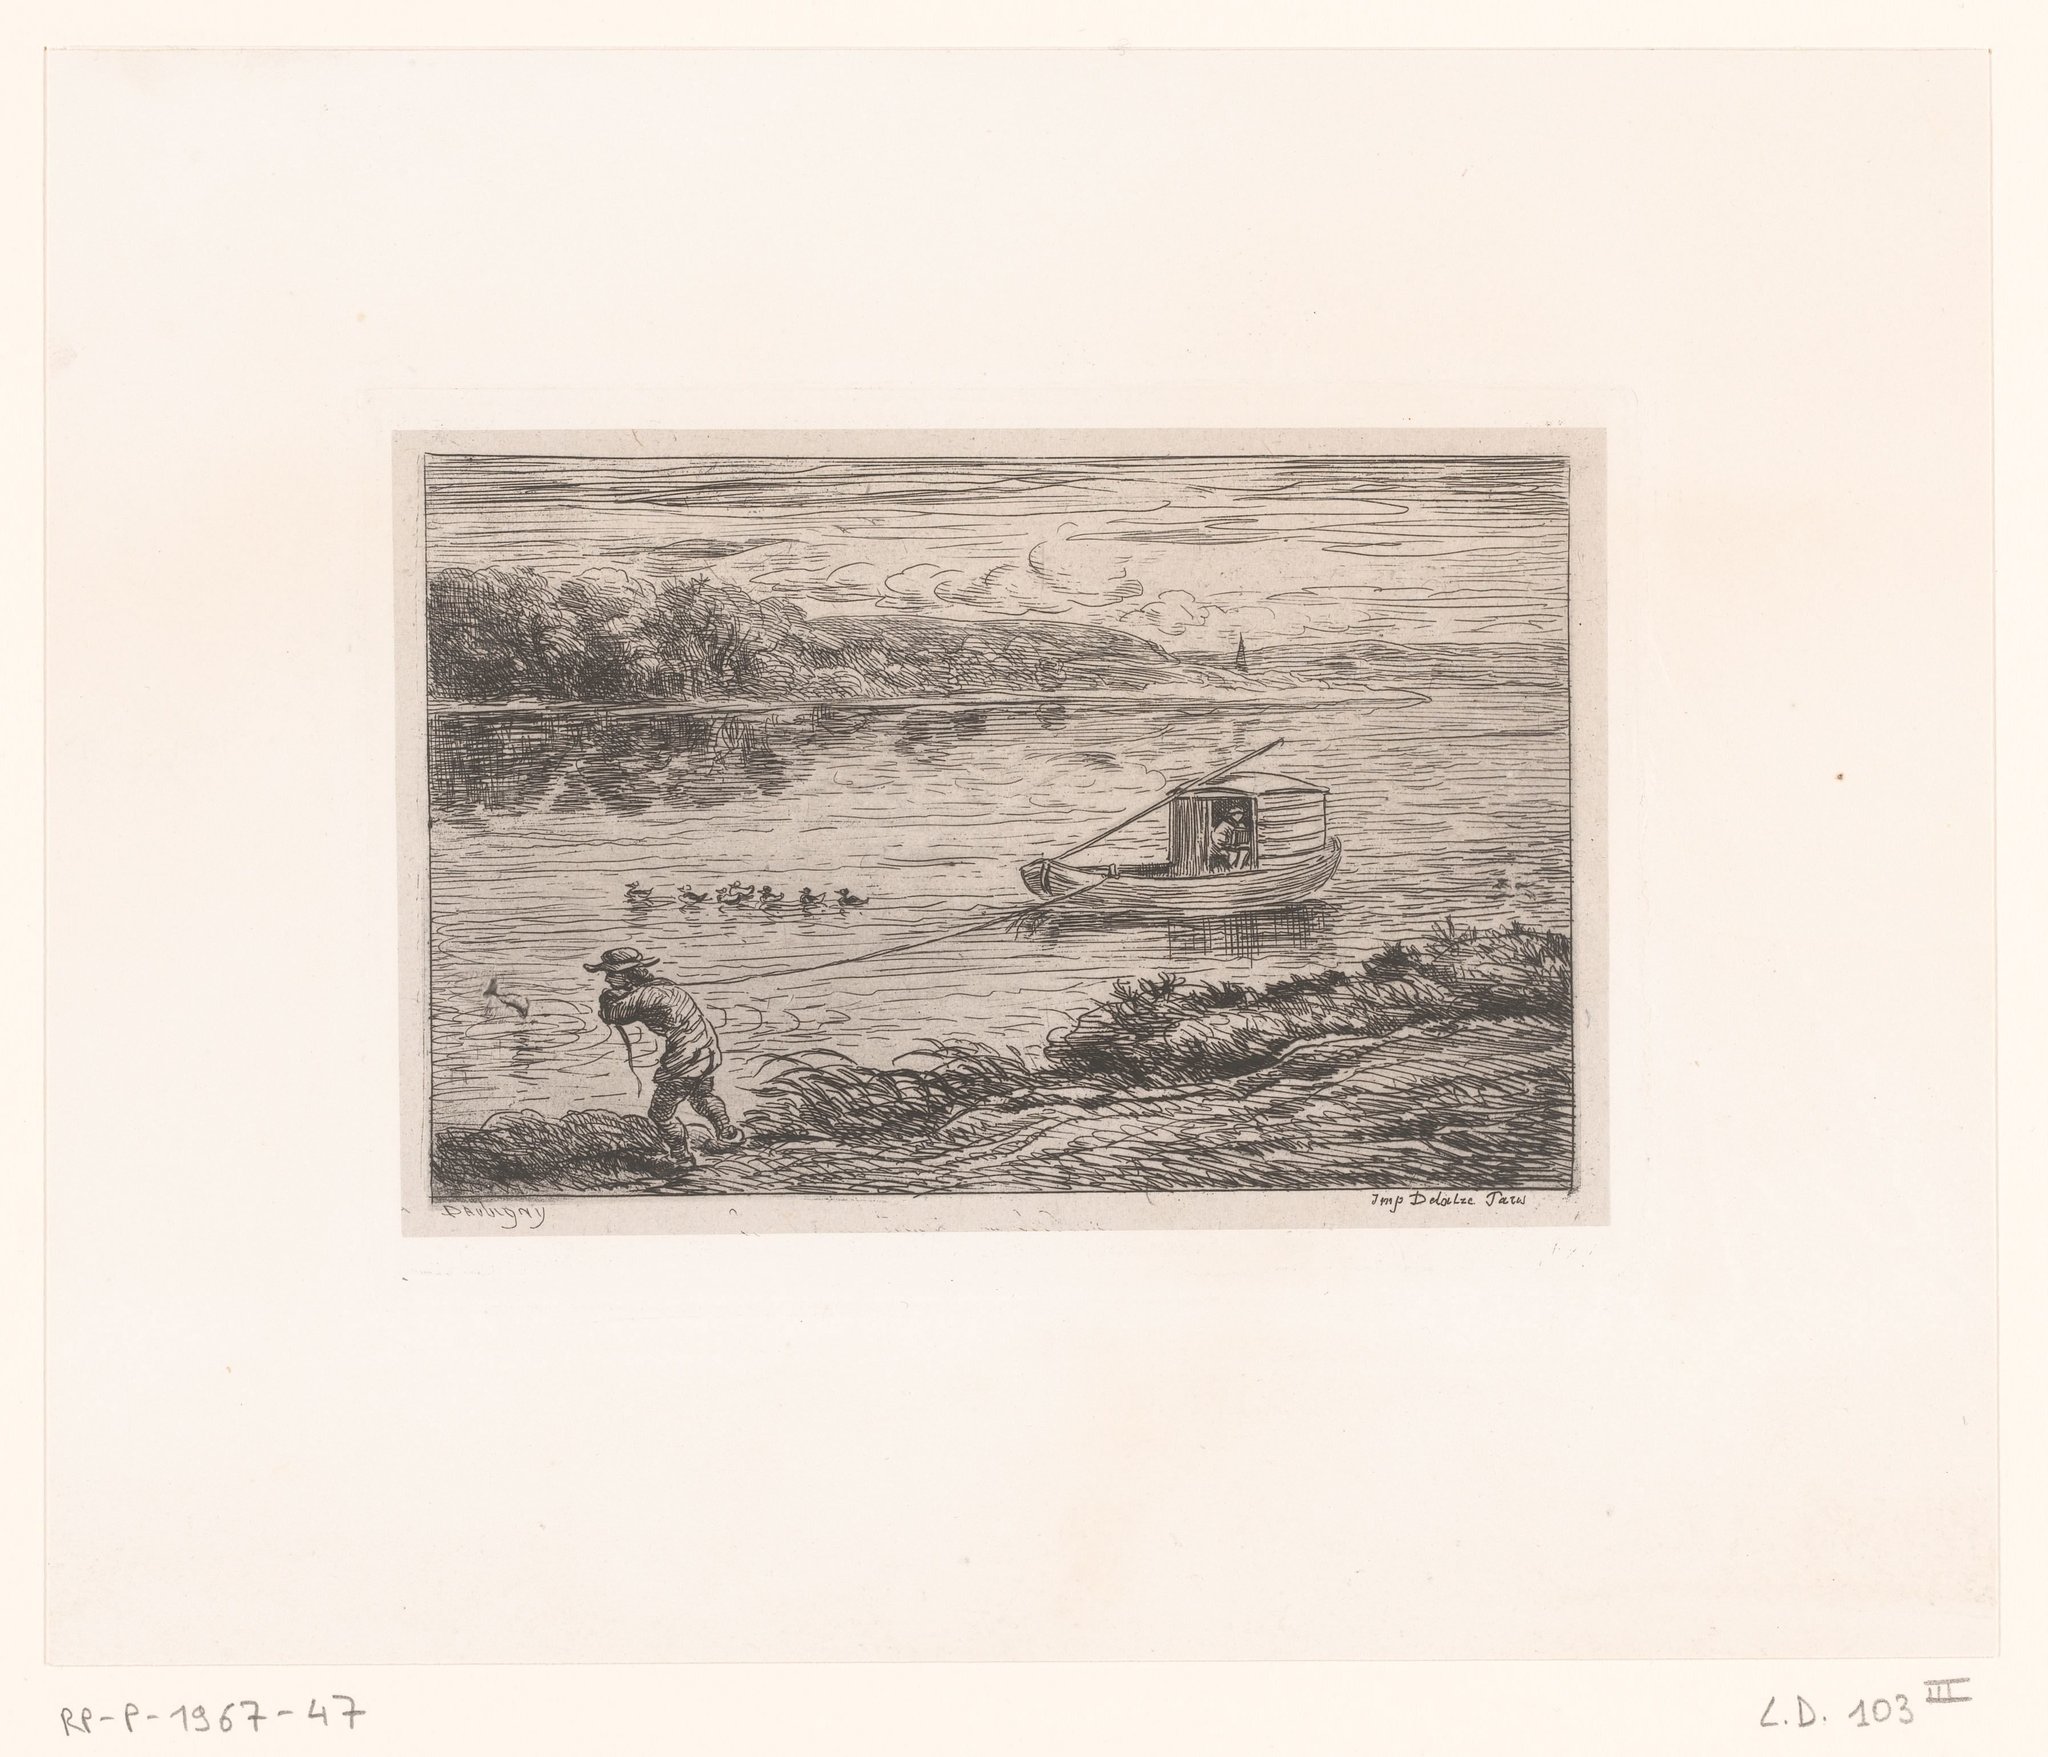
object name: print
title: Serie met landschappen en gebeurtenissen rond water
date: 1867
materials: paper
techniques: drypoint, engraving, etching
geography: paris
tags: landscapes, river, tow-boat, towing-barge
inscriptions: collector's mark: Lugt 2228, collector's mark: Lugt 2760